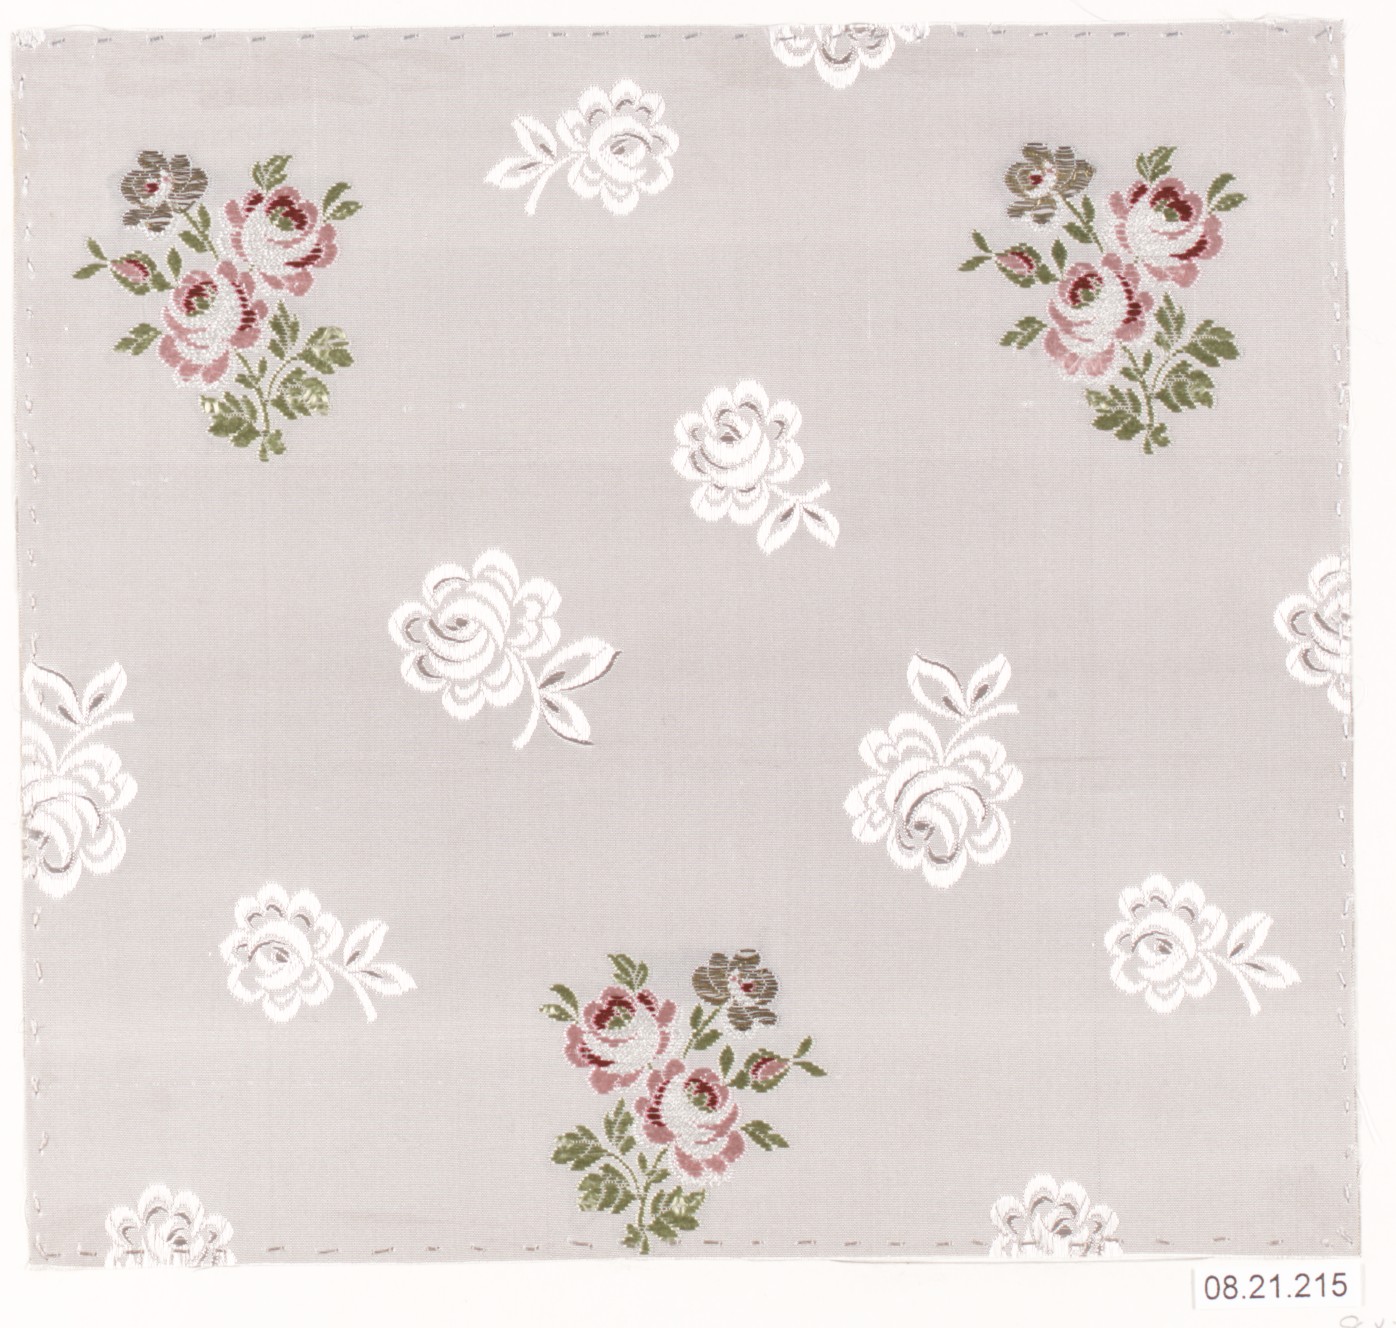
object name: textile sample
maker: Anonymous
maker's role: designer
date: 1900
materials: silk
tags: flowers